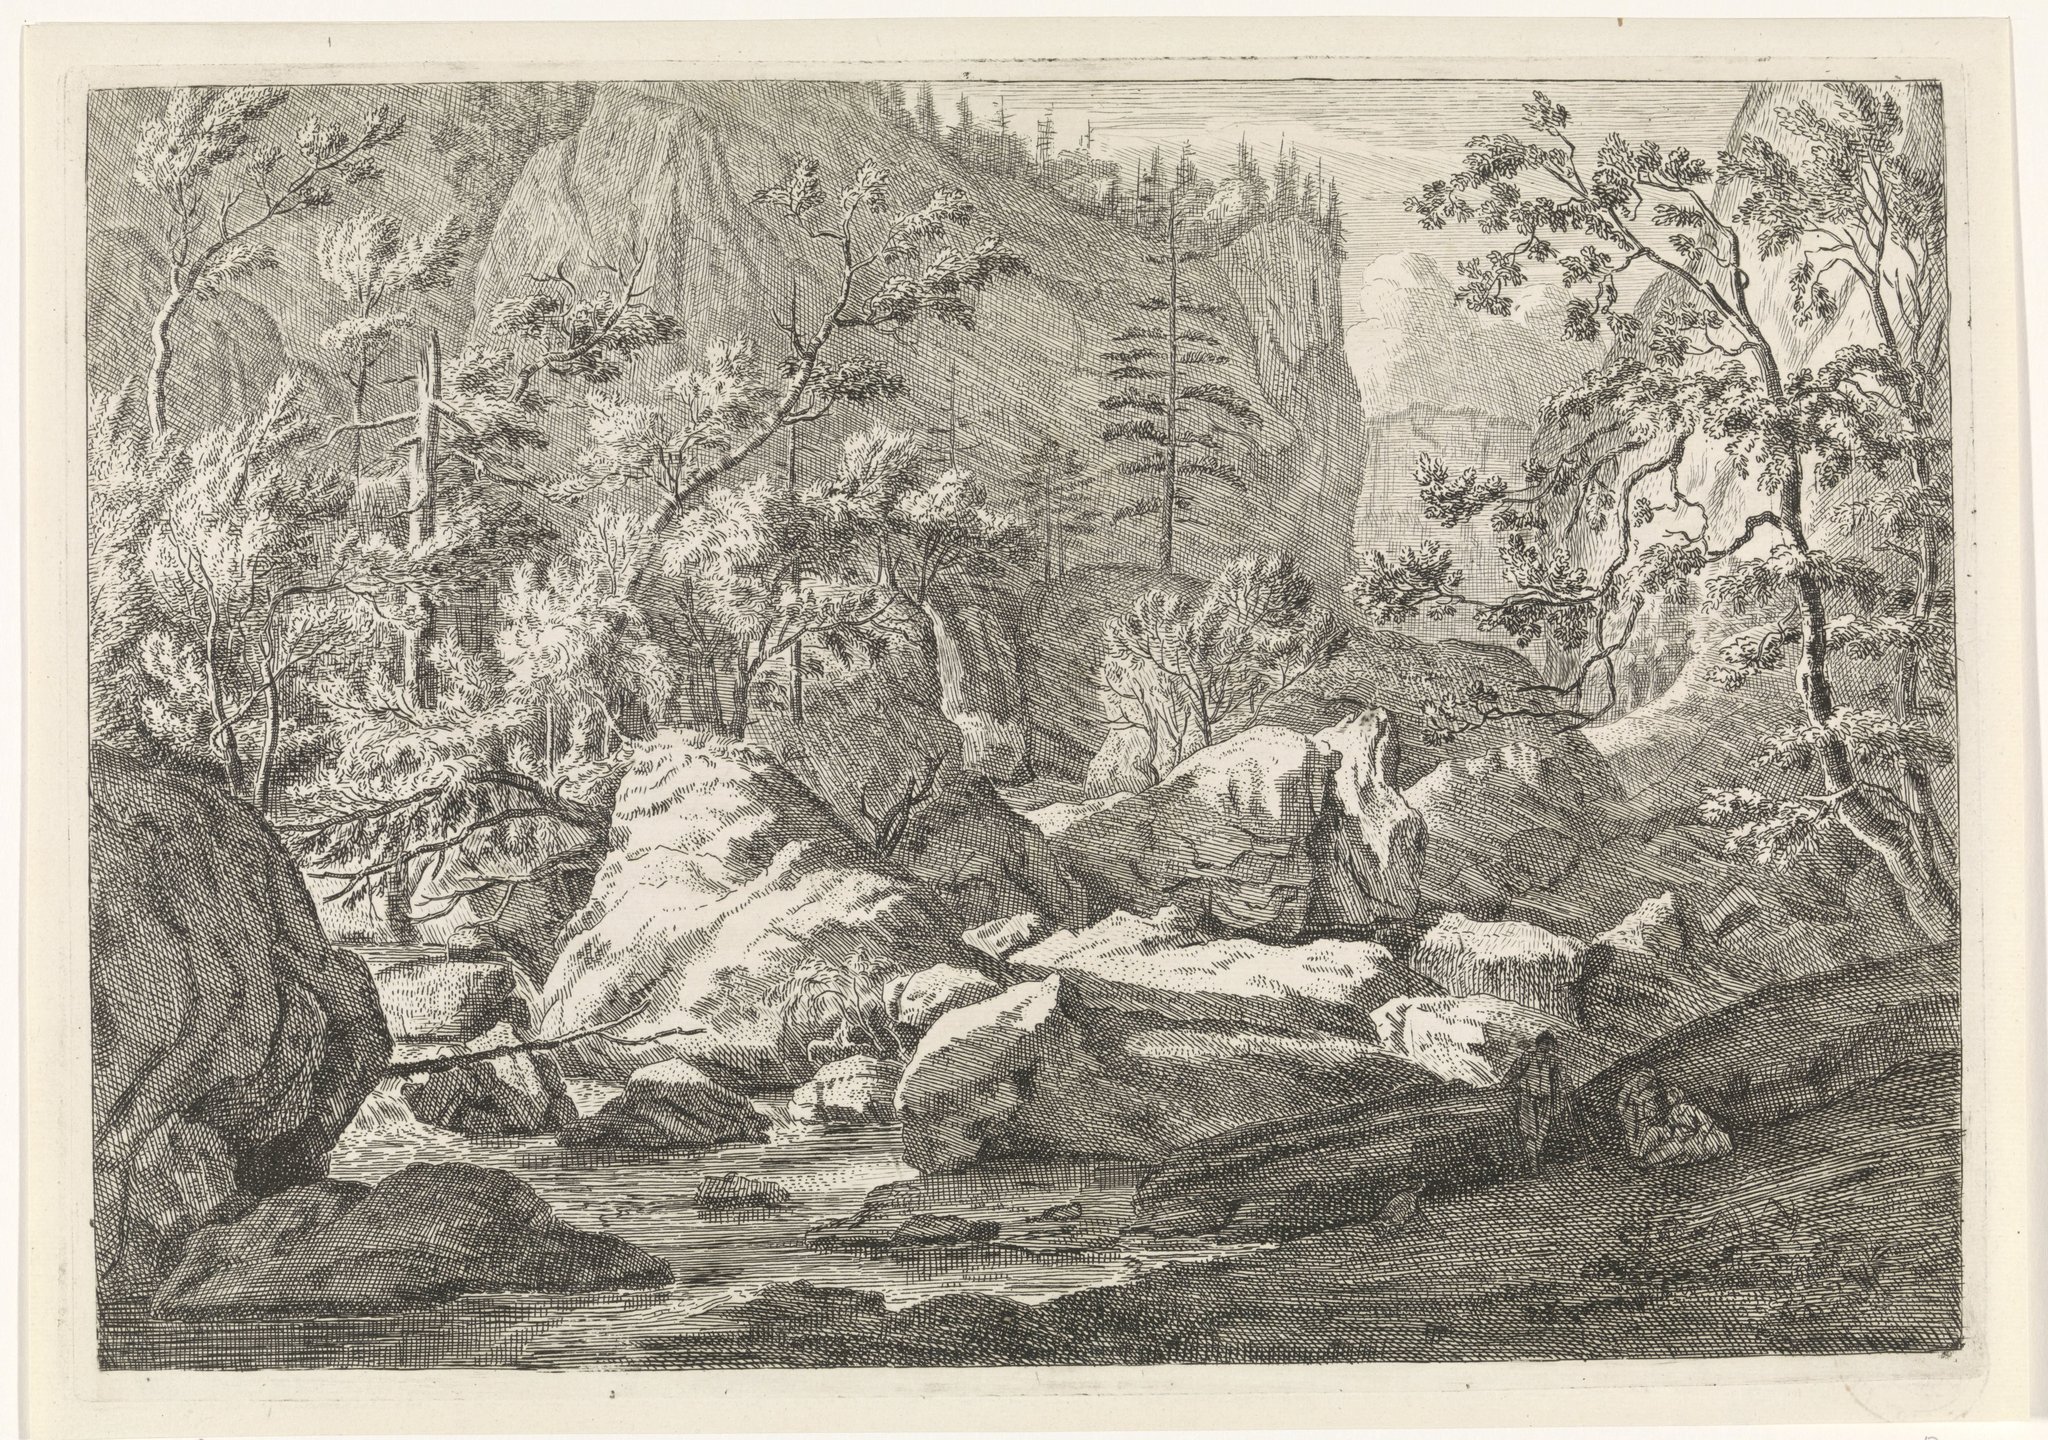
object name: print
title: Landschappen in het Chartreuzer-gebergte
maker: johannes glauber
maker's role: draughtsman, painter, print maker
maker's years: 1646-1726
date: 1656-1726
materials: paper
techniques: etching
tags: rock-formations, ravine, chasm, abyss, canyon (+ landscape with figures, staffage)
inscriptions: collector's mark: Lugt 240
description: Gezicht op een ravijn. Op de voorgrond een rivier met aan de oevers enkele zittende figuren. De prent maakt deel uit van een serie met berglandschappen in het Chartreuzer-gebergte..